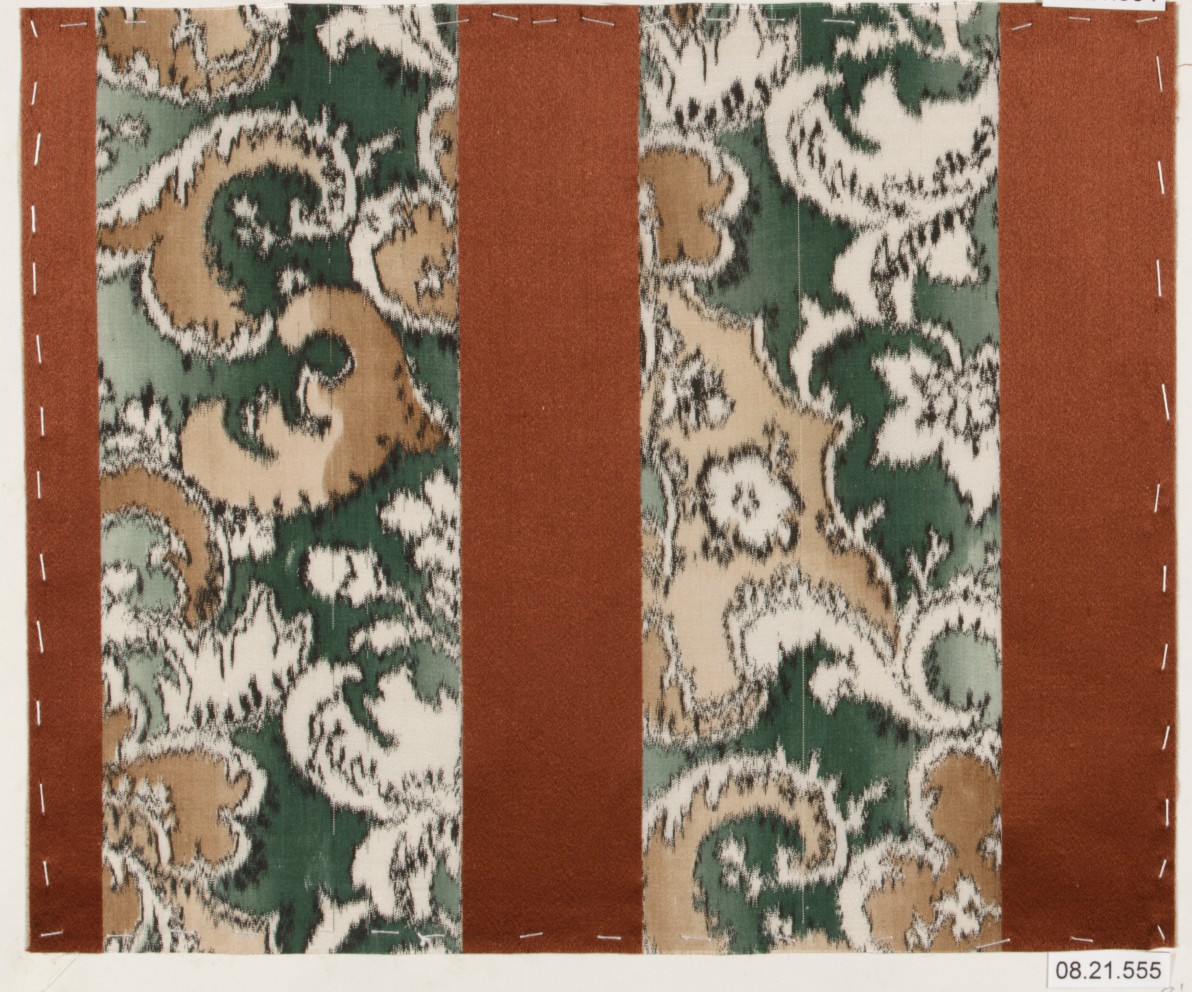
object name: textile sample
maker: Anonymous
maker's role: designer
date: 1900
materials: silk